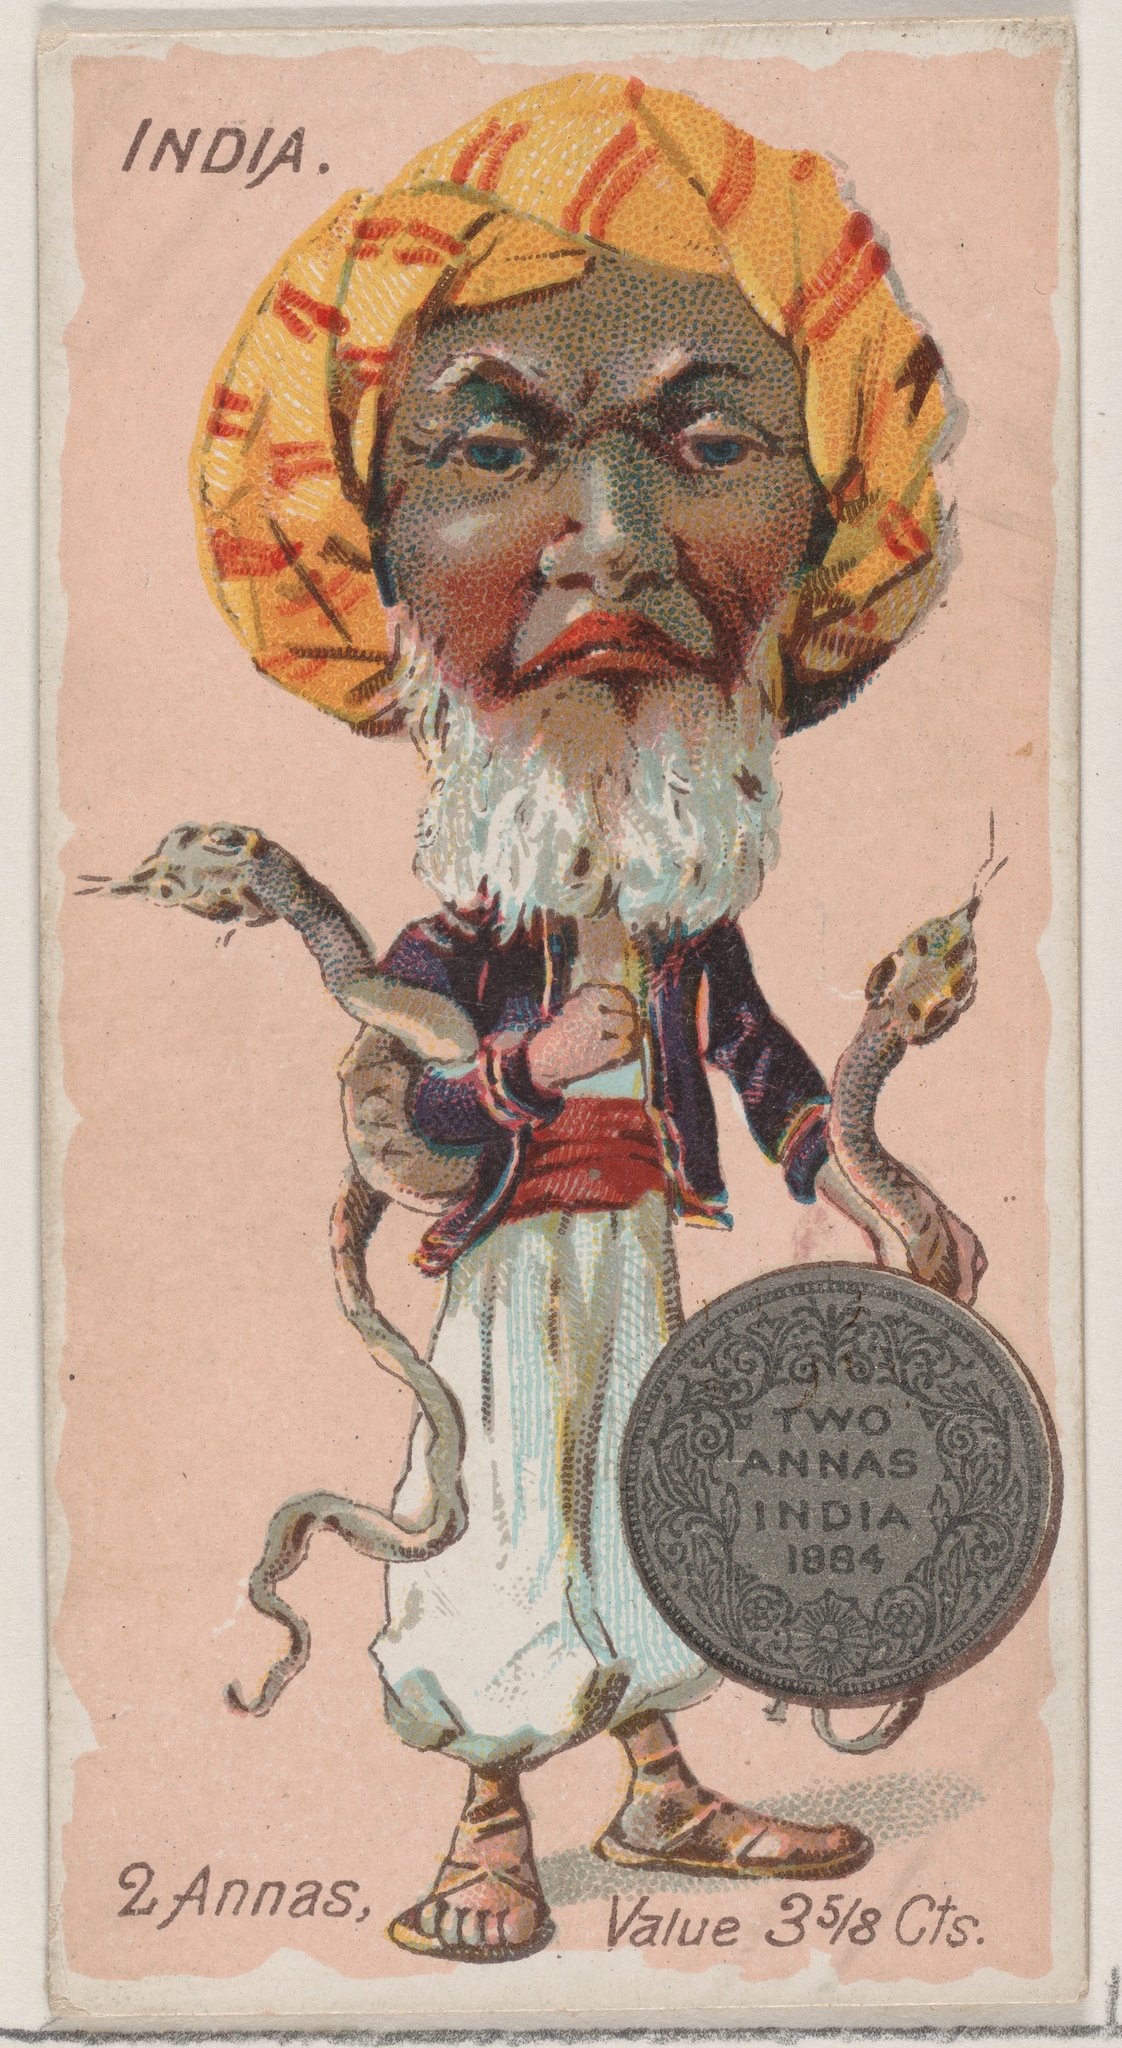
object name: print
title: Caricatured Indian, 2 Annas, from the series Coins of All Nations (N72, variation 2) for Duke brand cigarettes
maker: w. duke, sons & co.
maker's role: publisher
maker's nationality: american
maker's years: 1870-1920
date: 1889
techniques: color lithograph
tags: men,snakes,coins